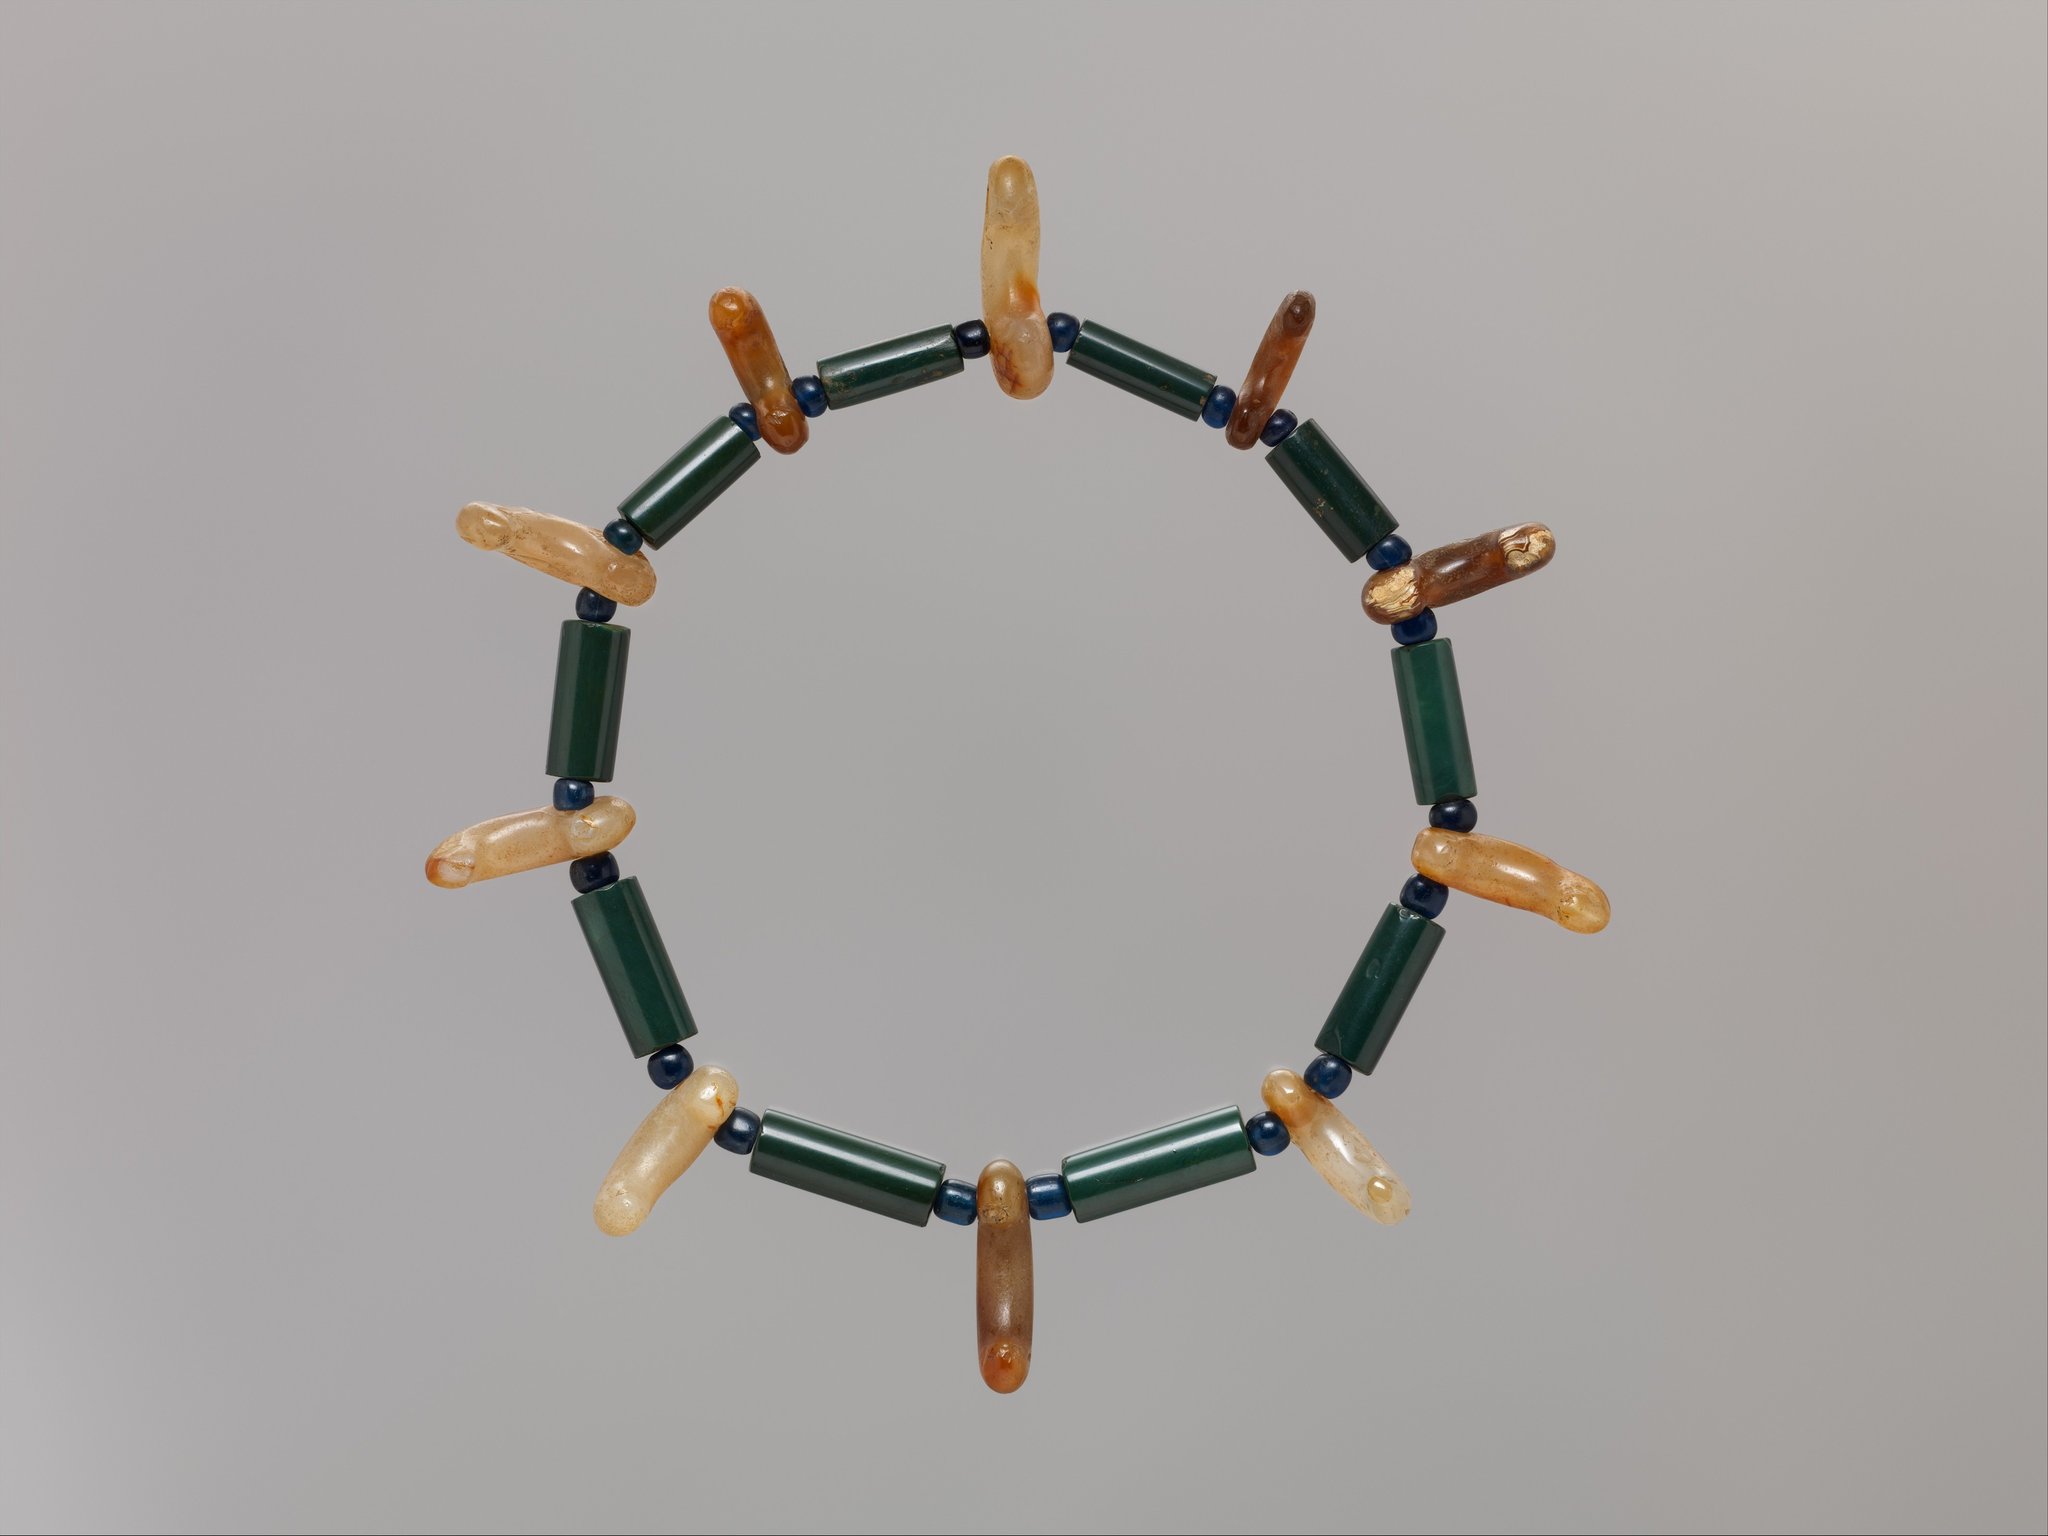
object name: necklace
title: Necklace with Claw-Shaped Beads (Magatama)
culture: japanese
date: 601-700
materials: stone, jasper